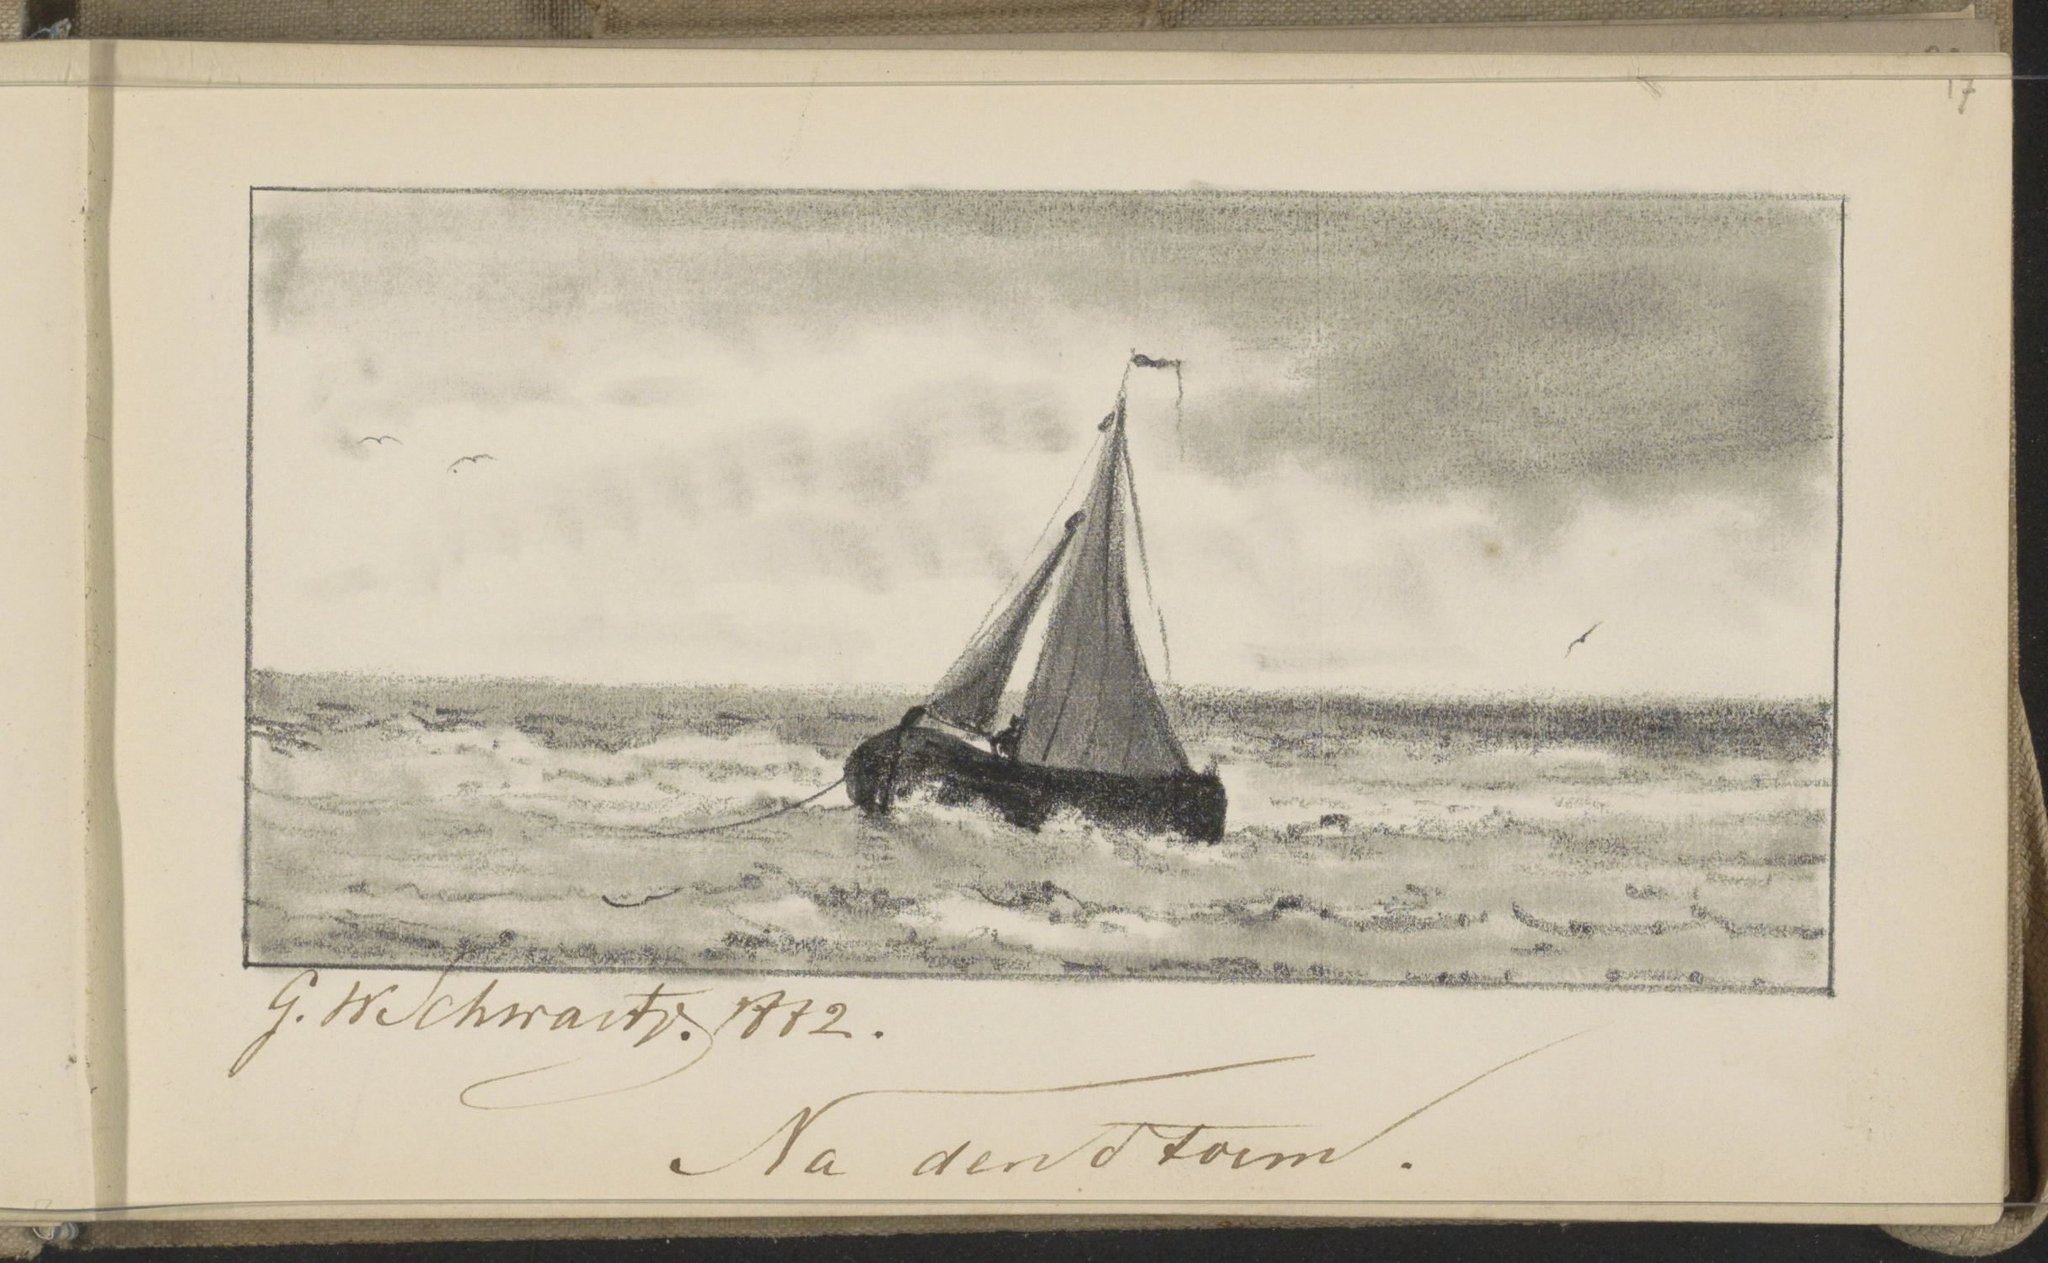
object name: sketchbook leaf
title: Na den storm.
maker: george washington schwartze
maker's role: draughtsman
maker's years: 1857-1909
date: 1882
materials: paper, pencil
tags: sailing-ship, sailing-boat, landscapes with waters, waterscapes, seascapes (in the temperate zone)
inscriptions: title: ‘Na den storm.’, signature and date: ‘G.W.Schwartze. 1882.’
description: Tekening in een kader. Blad 17 recto uit een schetsboek met 54 bladen.